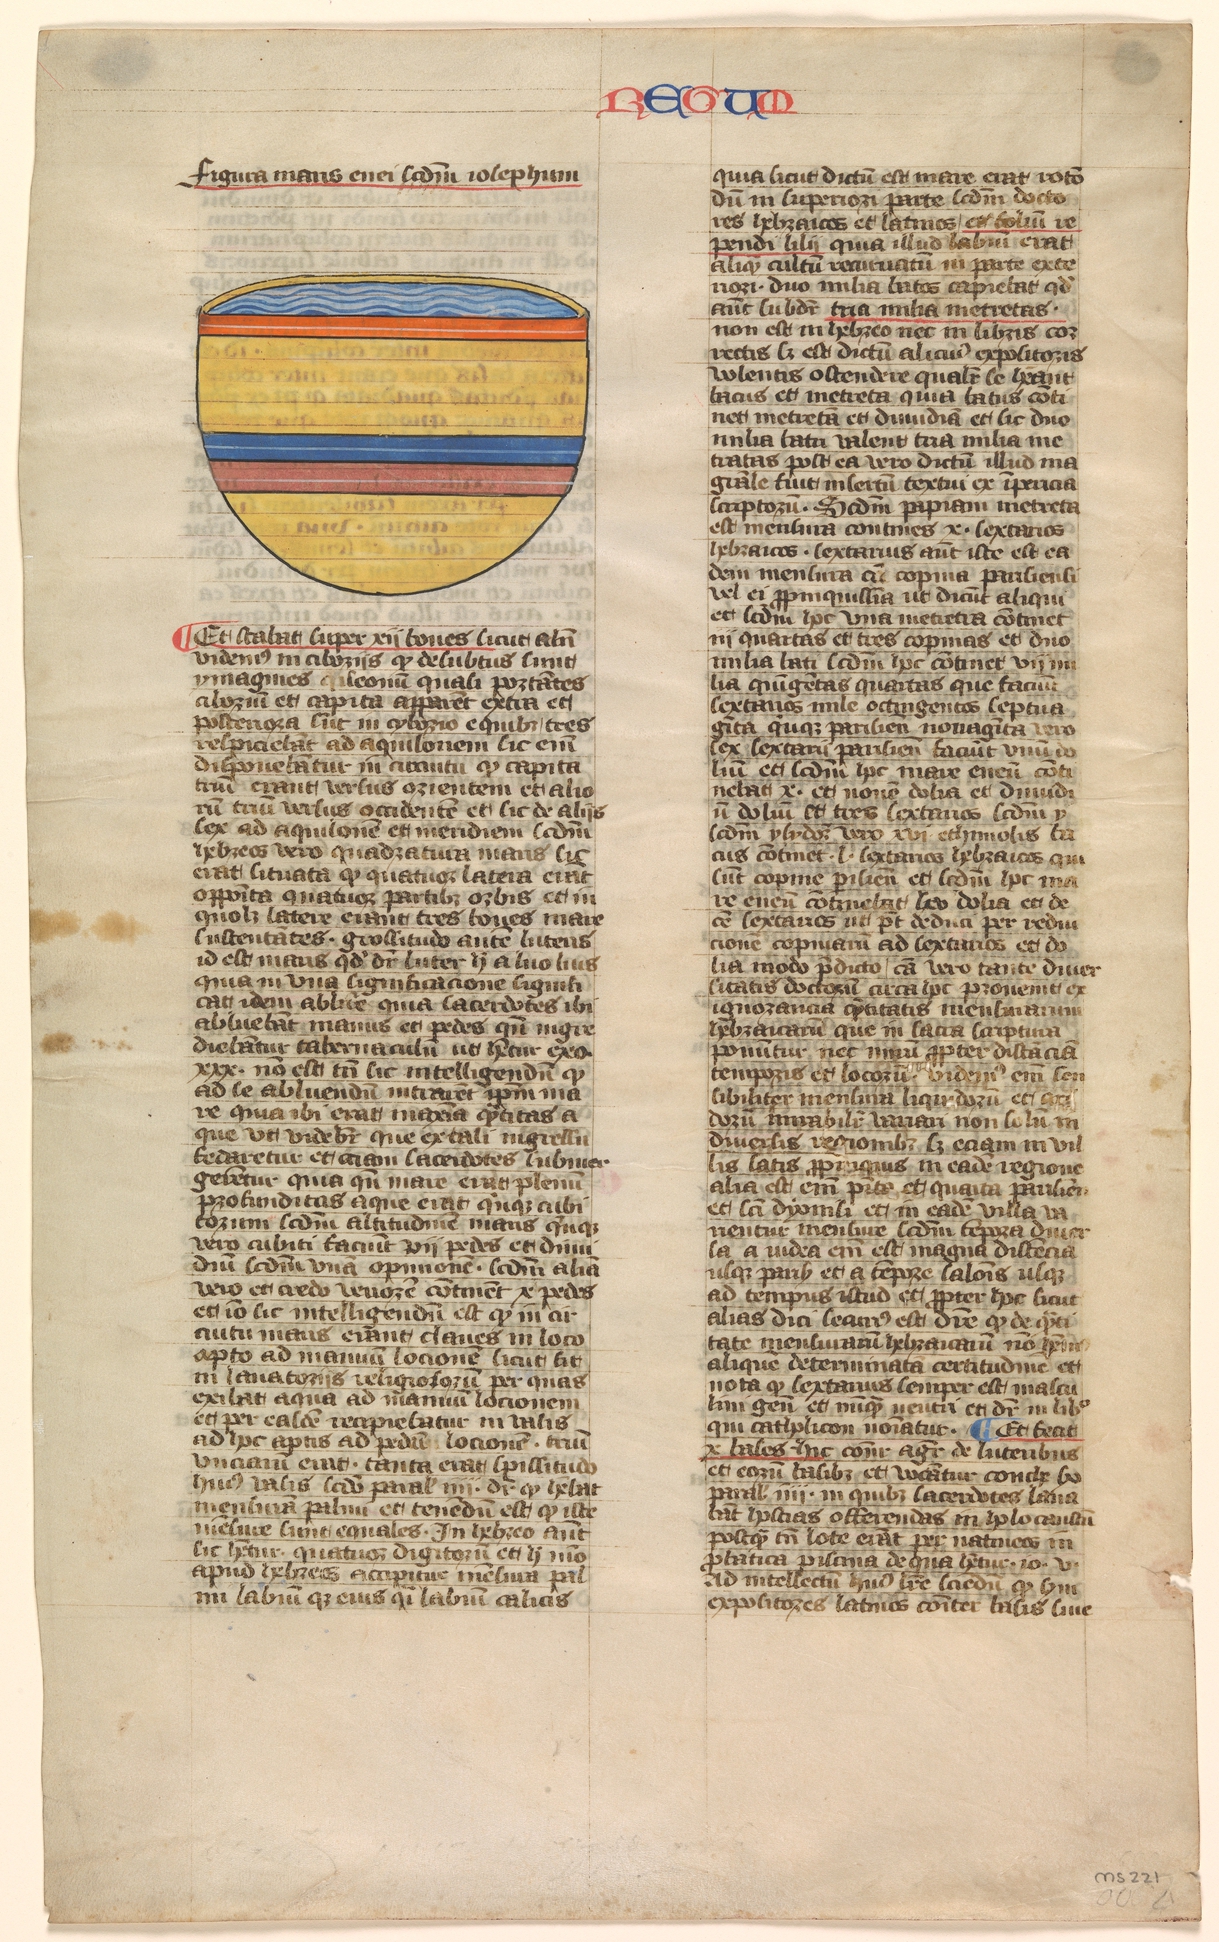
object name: manuscript leaf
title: Brazen Sea, one of six illustrated leaves from the Postilla Litteralis (Literal Commentary) of Nicholas of Lyra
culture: french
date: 1360-1380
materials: gold, ink, iron, parchment, watercolor